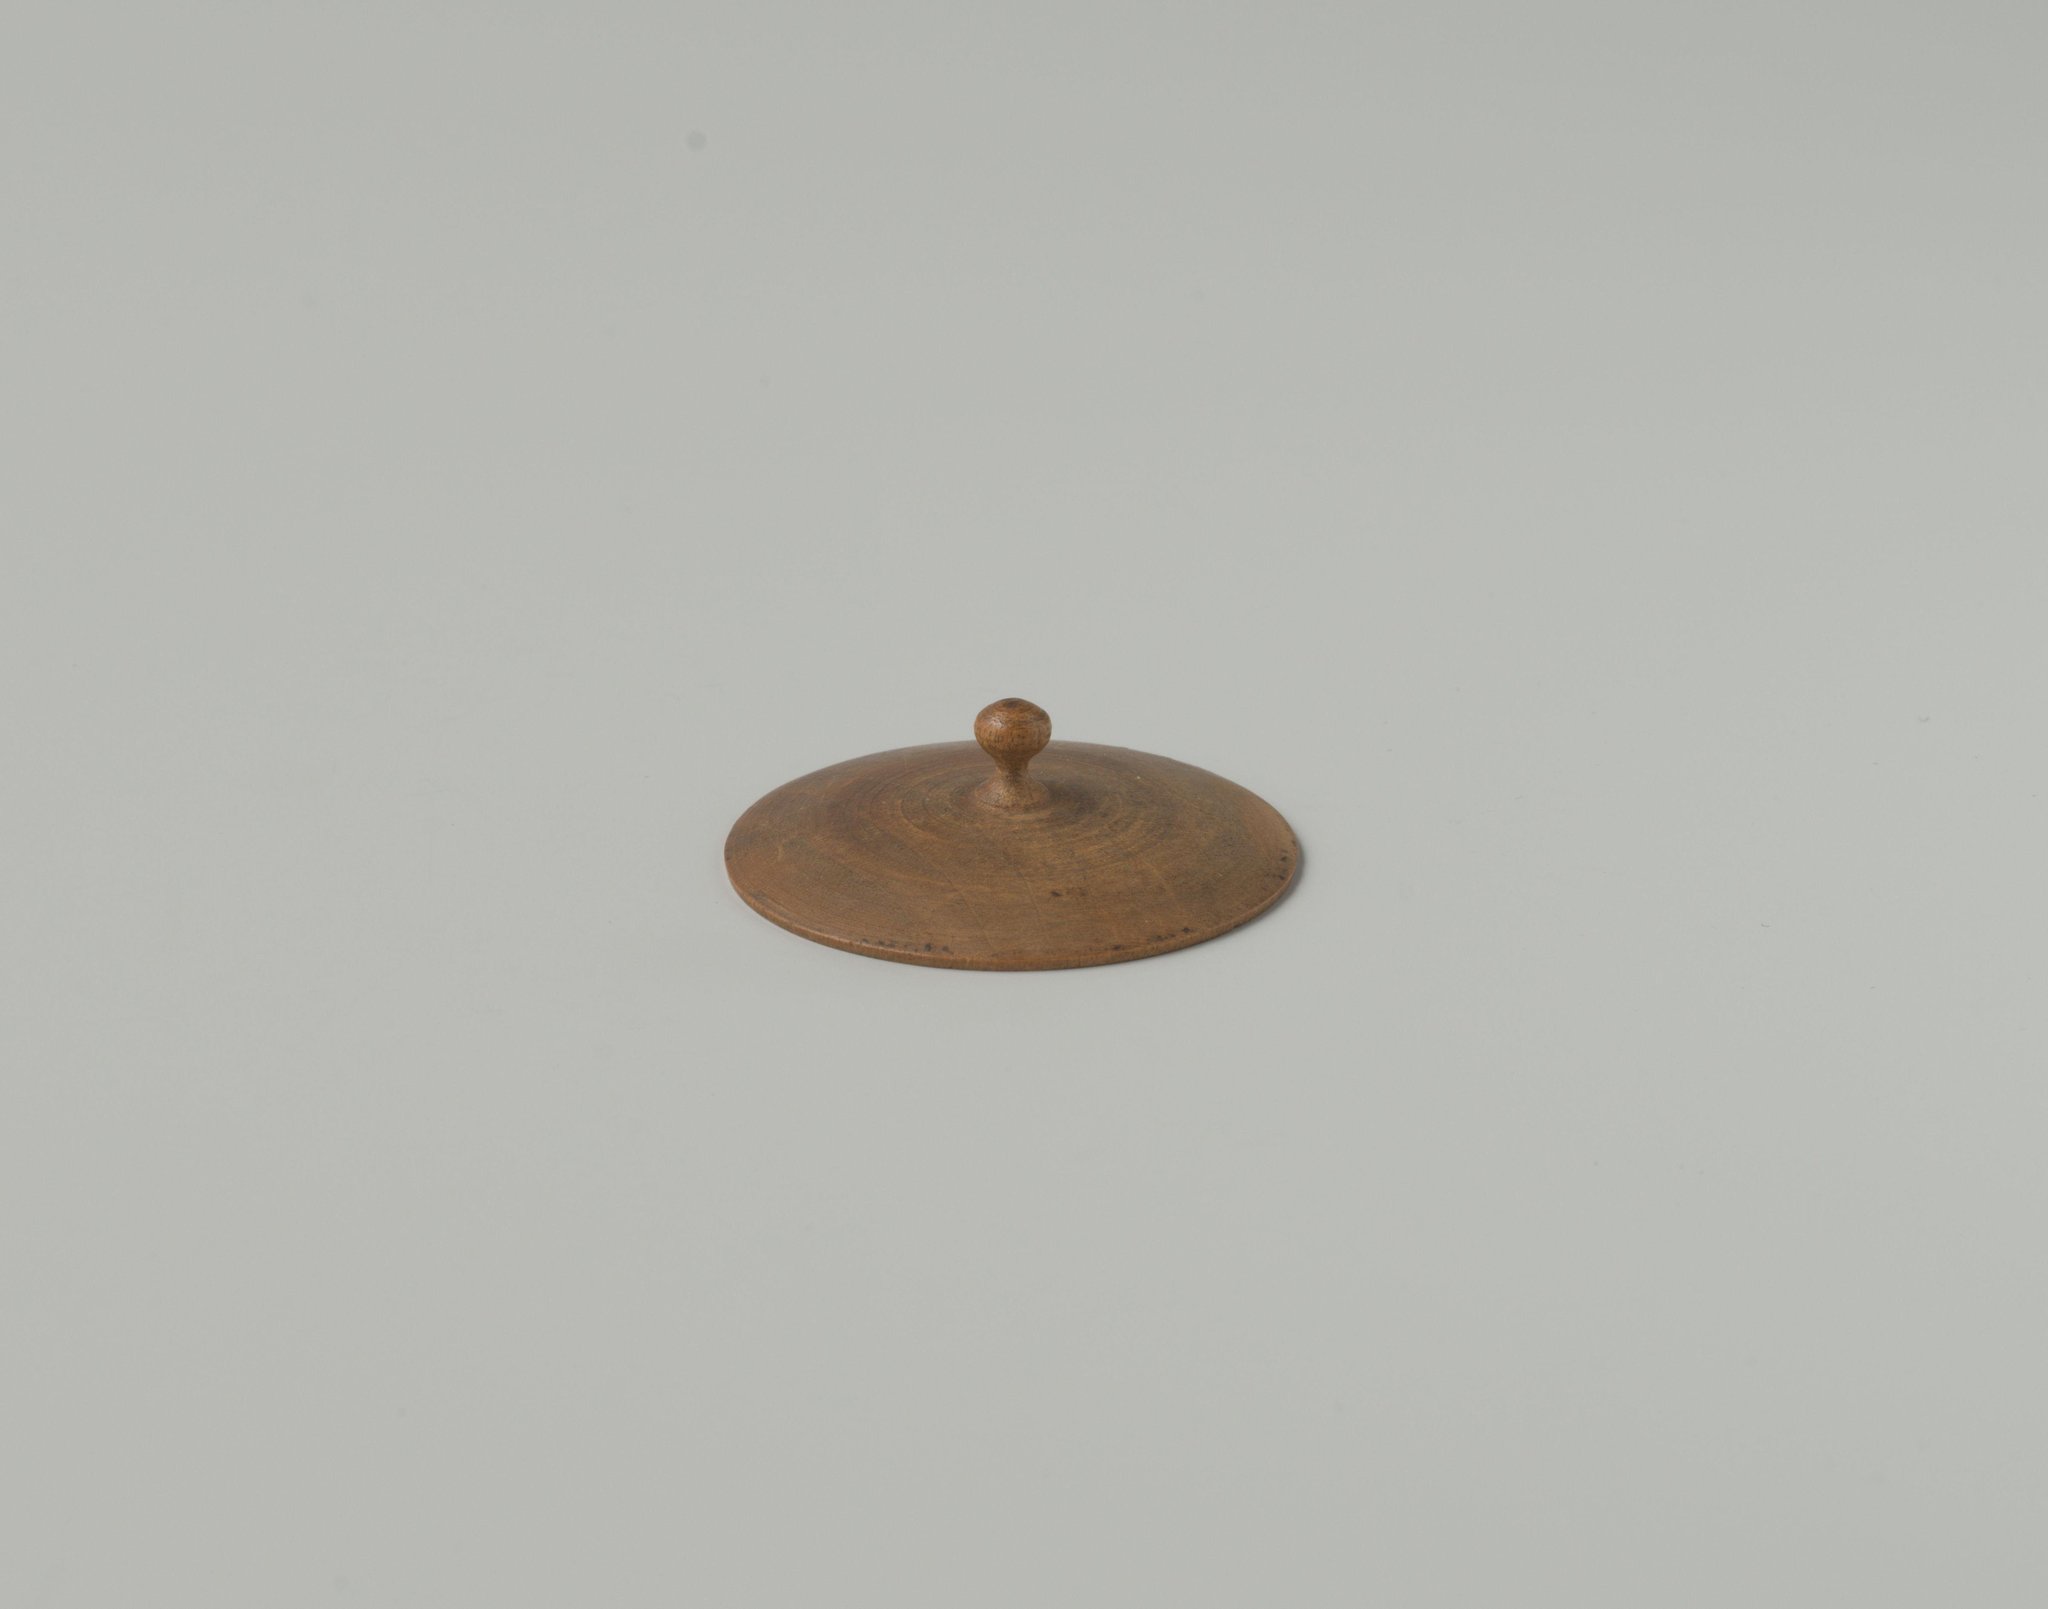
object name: lid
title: Ronde deksel met knop en vlakke onderkant, gedraaid uit esdoornhout. Mogelijk het deksel op het secreet gat.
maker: Anonymous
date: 1680-1710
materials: wood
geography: amsterdam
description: Ronde deksel met knop en vlakke onderkant, gedraaid uit esdoornhout. Mogelijk de deksel op het secreet gat.